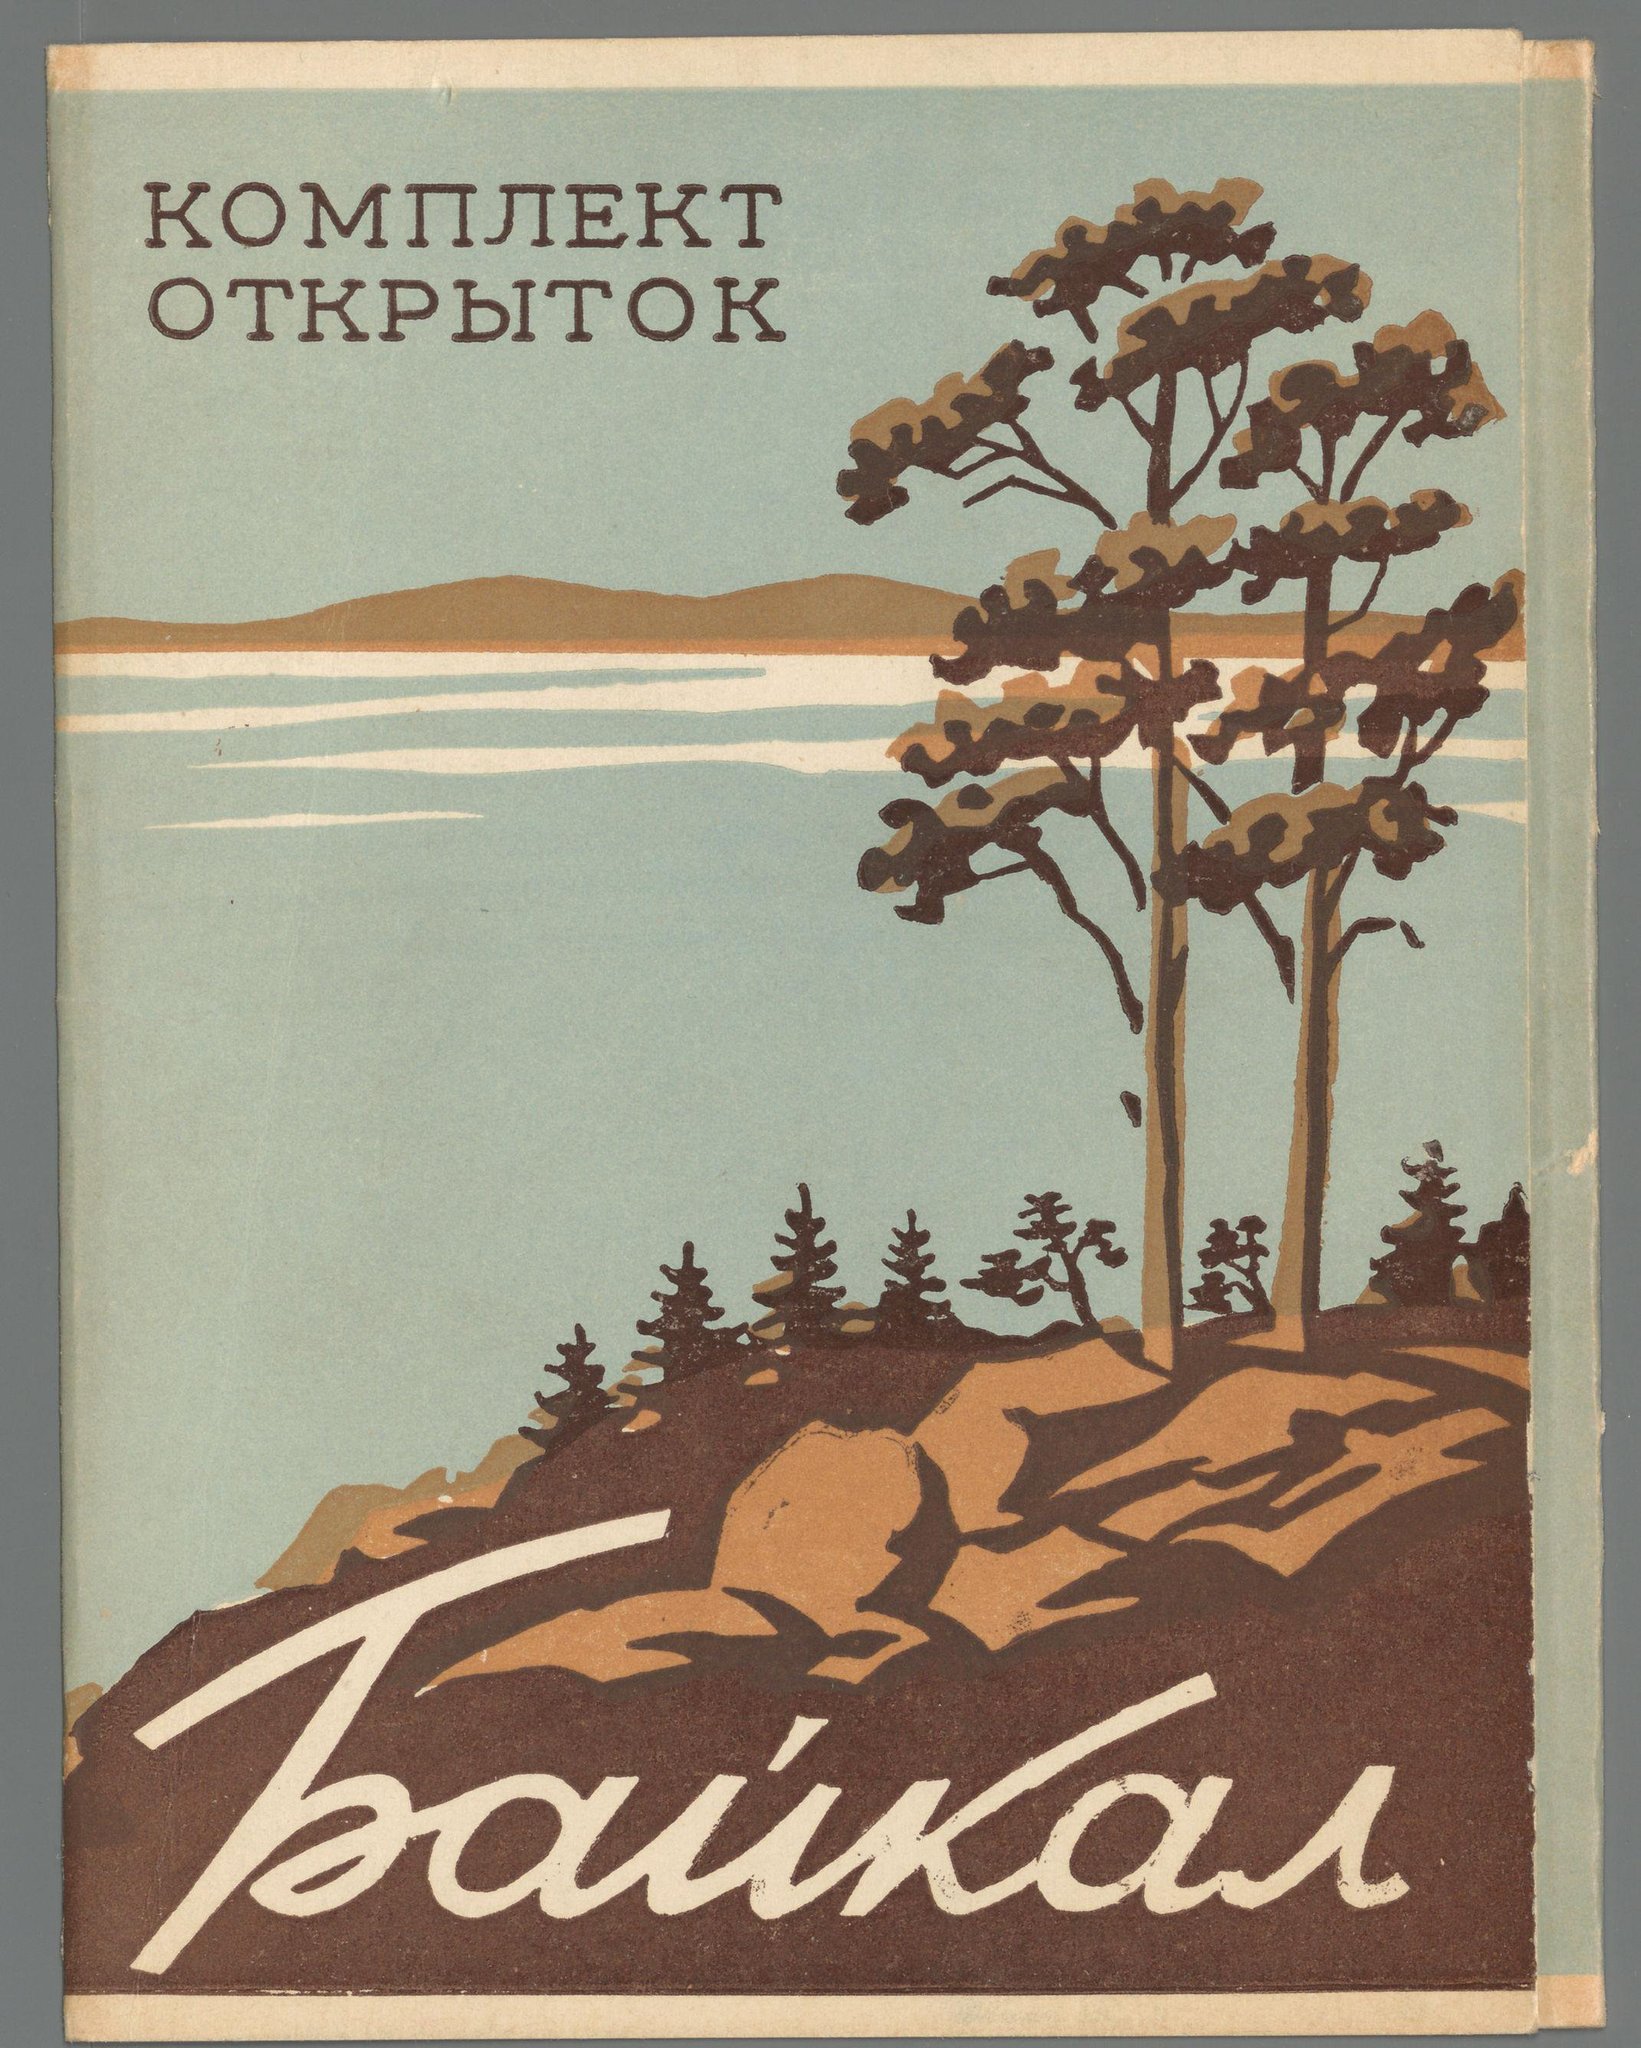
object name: wrapper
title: Omslag voor vijftien prentbriefkaarten met gezichten van het Baikalmeer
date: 1956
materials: cardboard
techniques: lithograph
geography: lake baikal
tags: lake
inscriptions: date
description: De titel op object staat in het Russisch.